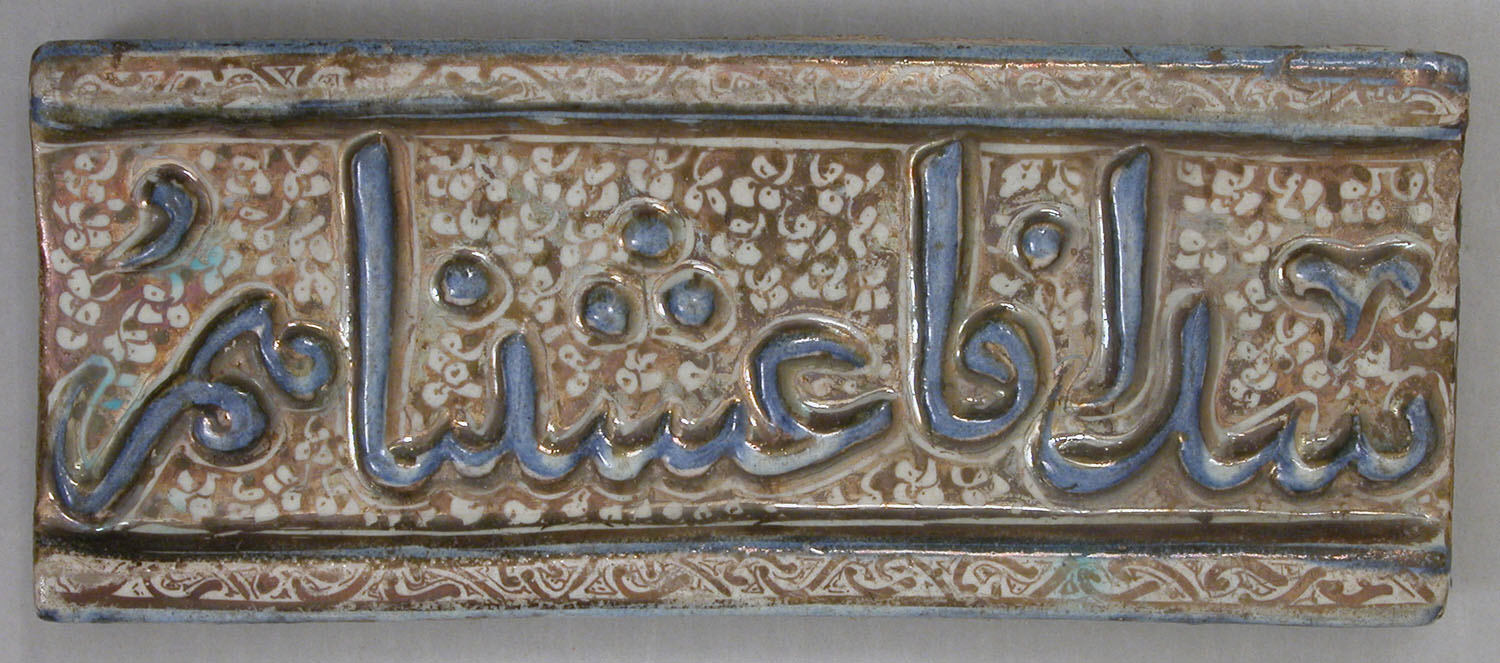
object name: tile from a frieze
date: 1267-1300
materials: stonepaste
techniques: glazing, luster painting, molding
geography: iran